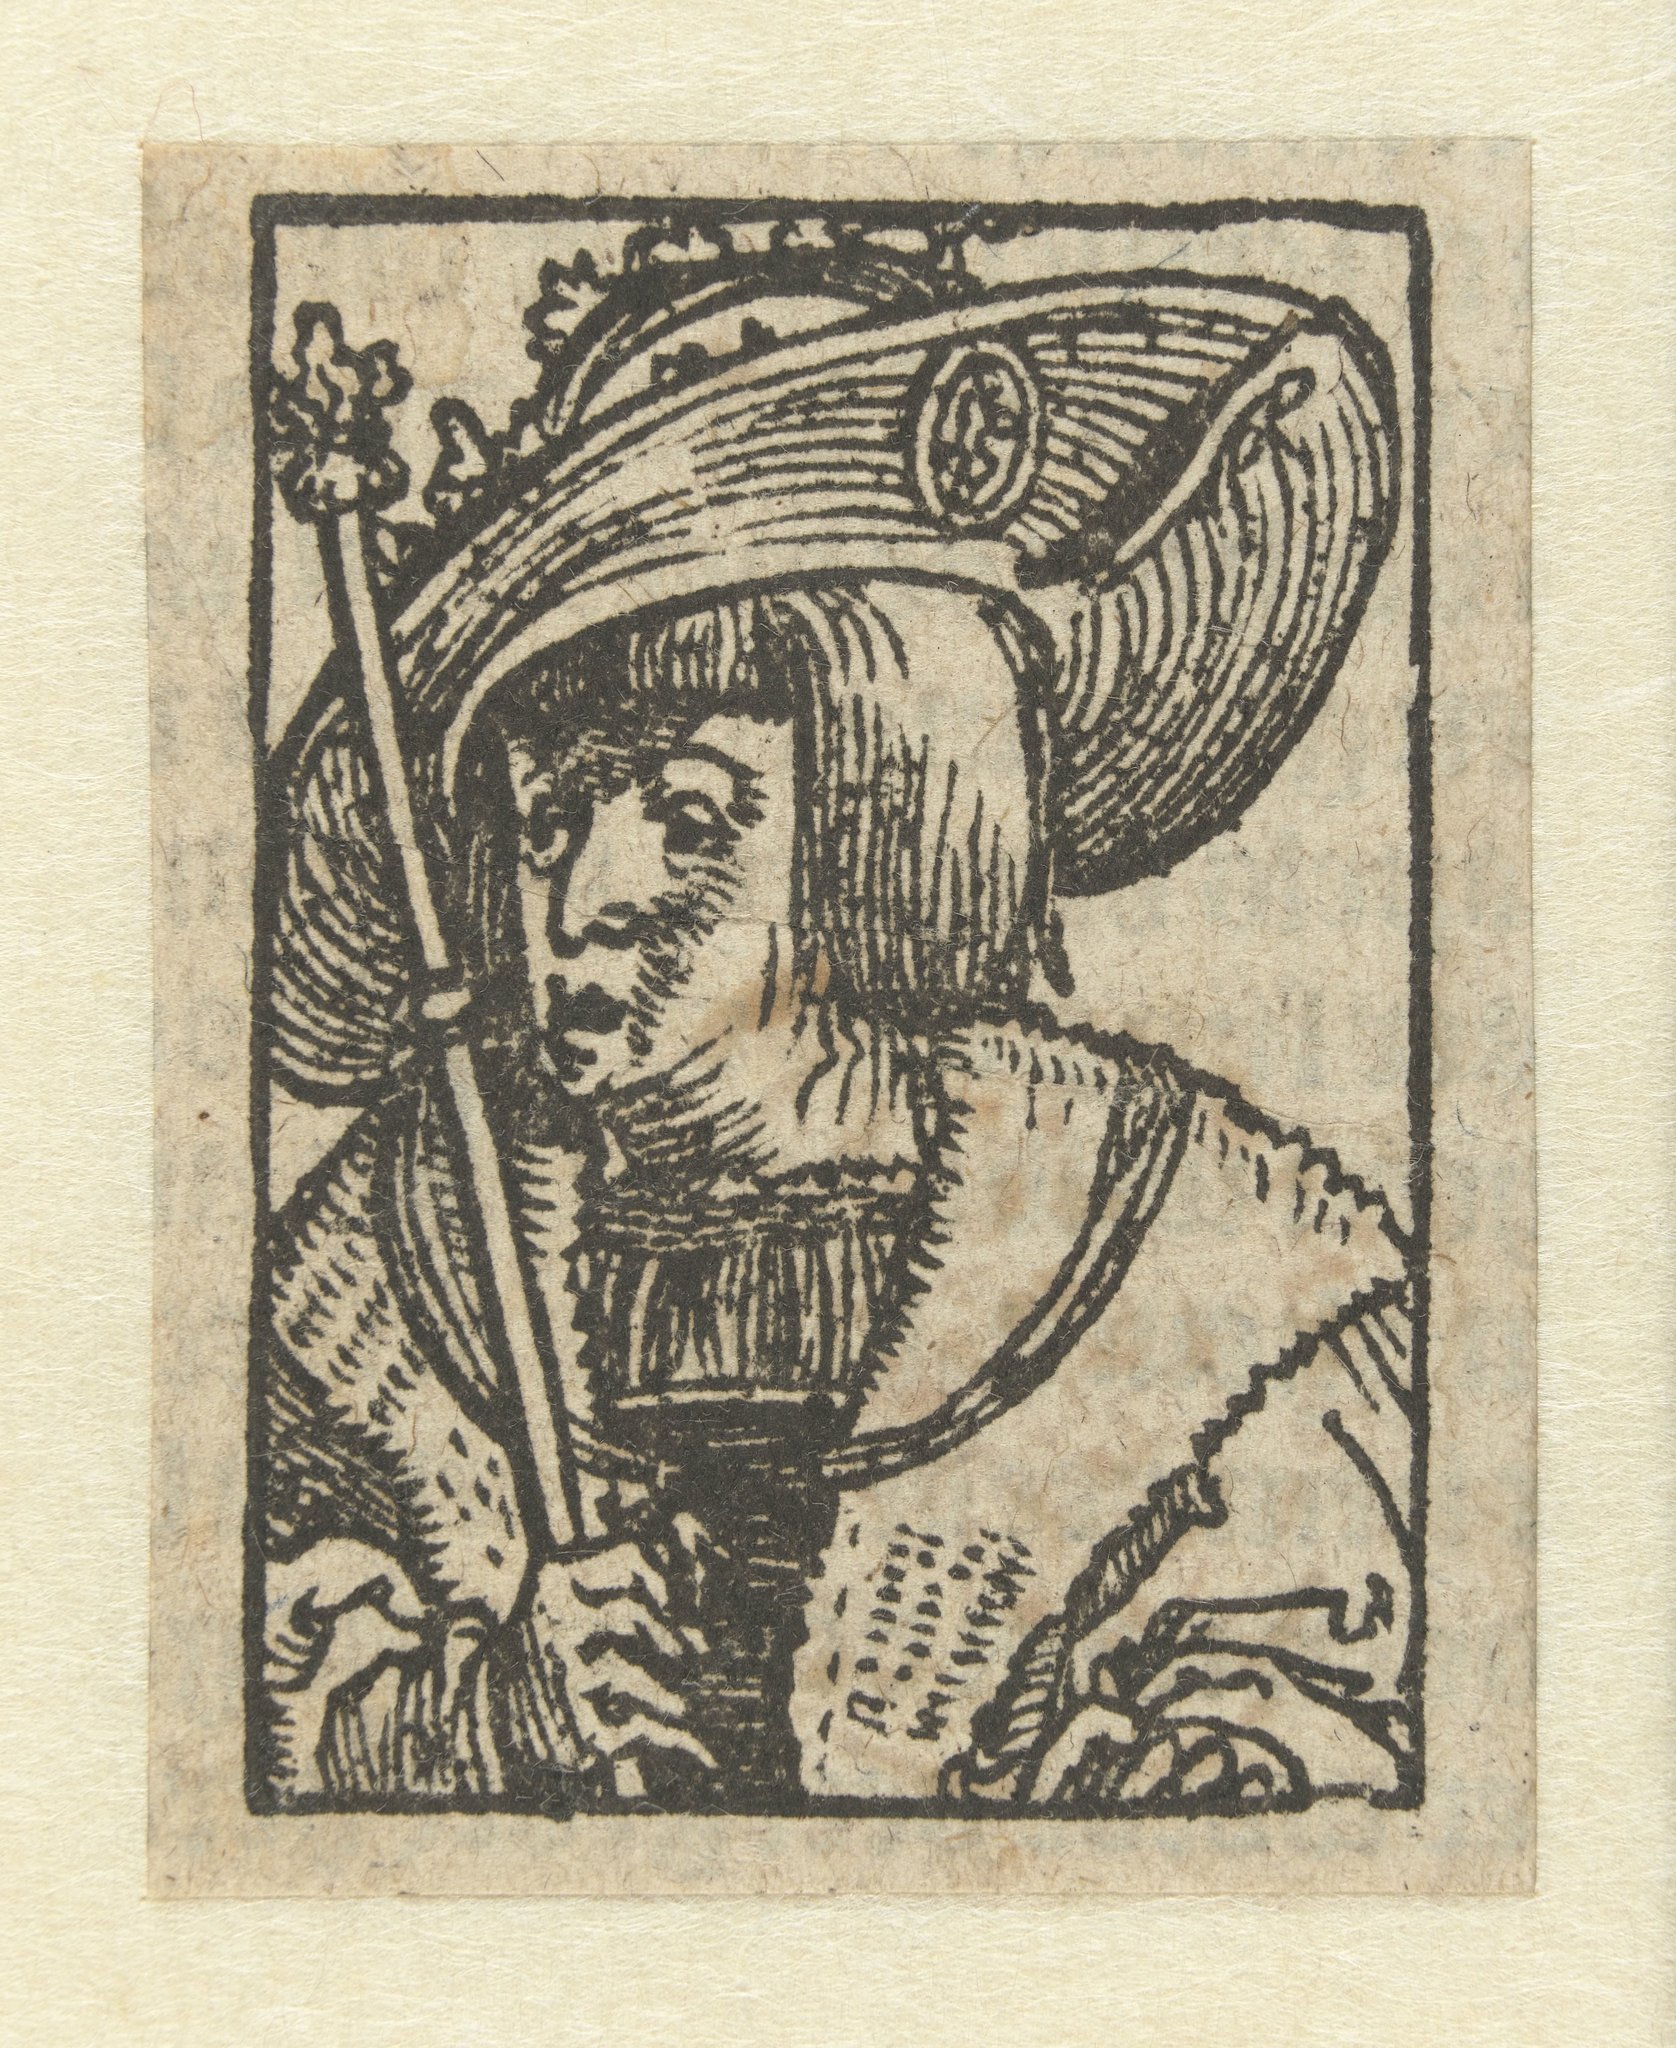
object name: book illustration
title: Portret van keizer Karel V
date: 1530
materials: paper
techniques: woodcut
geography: low countries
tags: ghent, charles v (holy roman emperor and king of spain)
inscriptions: collector's mark: Lugt 240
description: Eén van zeven houtsnede-portretten als illustratie voor "Van Brabant, Die Excellente Cronike Van Vlaendere, Hollat, Zeelant Int Generael", gedrukt bij Jan van Doesborch te Antwerpen in juni 1530.